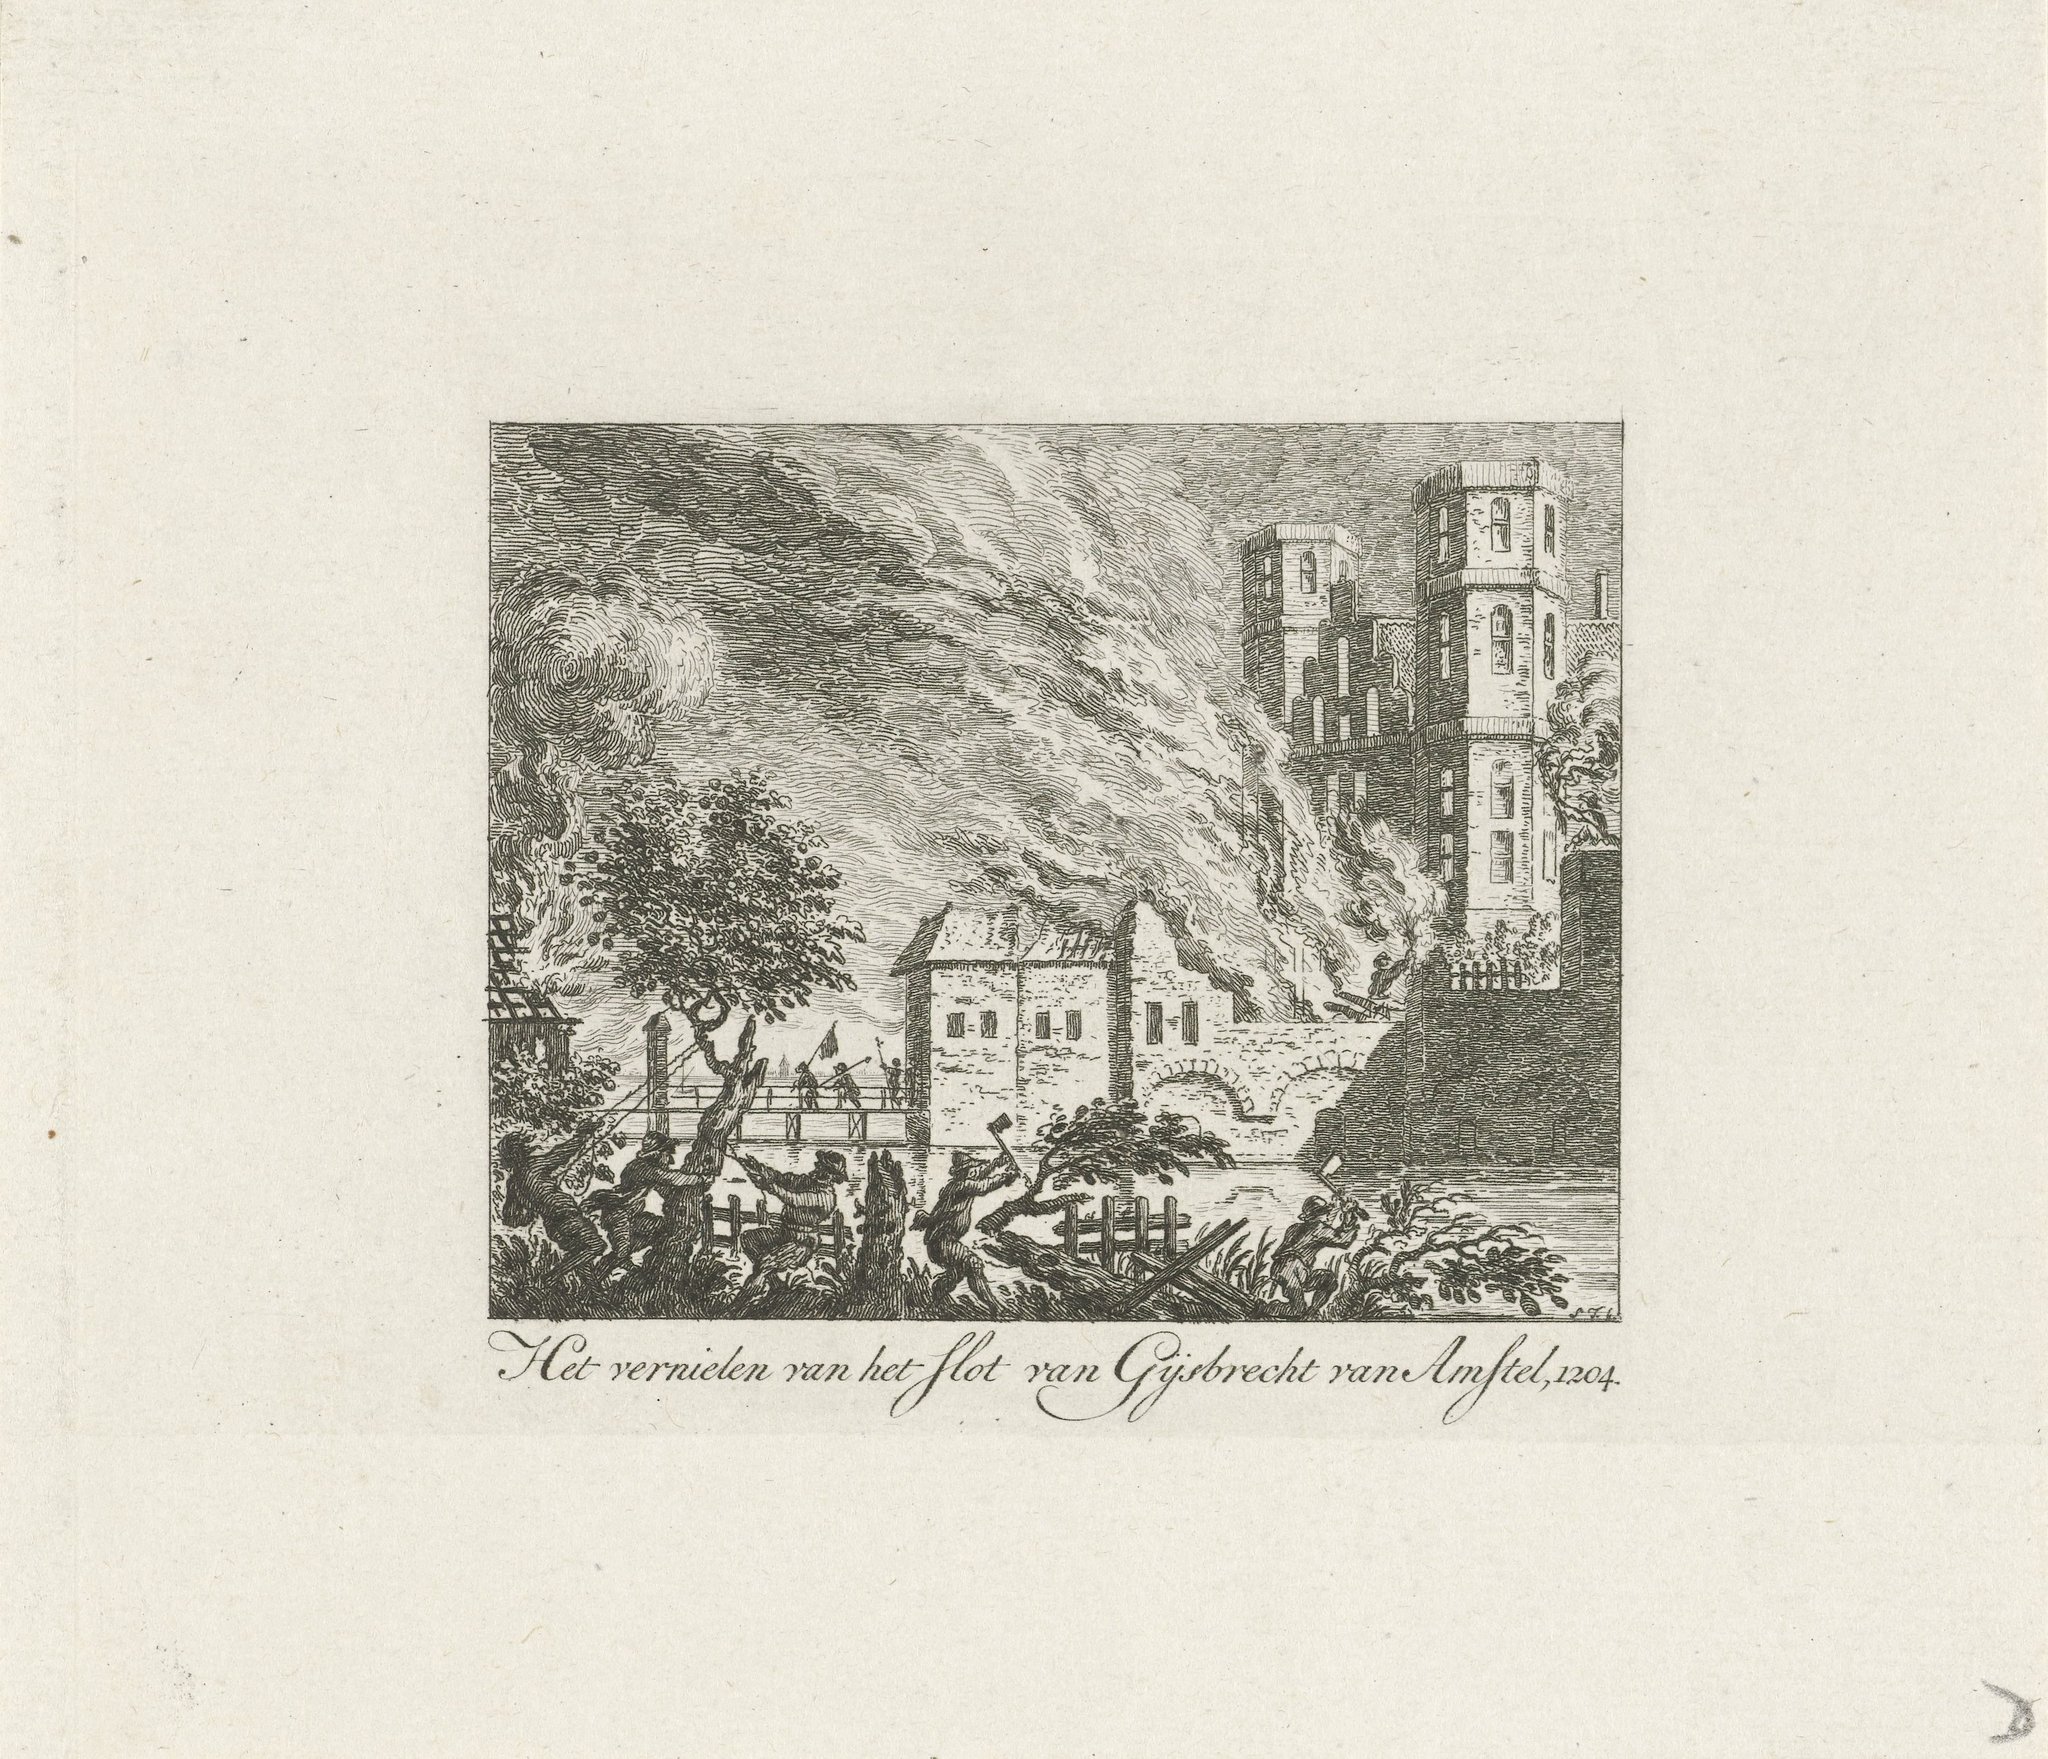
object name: print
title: Vernieling van het slot van Gijsbrecht II van Amstel, 1204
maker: simon fokke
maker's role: draughtsman, print maker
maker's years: 1712-1784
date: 1722-1784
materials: paper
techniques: etching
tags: destruction of buildings (~ revolutionary action)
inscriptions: collector's mark: Lugt 2228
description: Terwijl het slot in brand staat, zijn figuren op de voorgrond hout aan het hakken. Op de brug over de slotgracht verlaten muitende figuren de vesting.